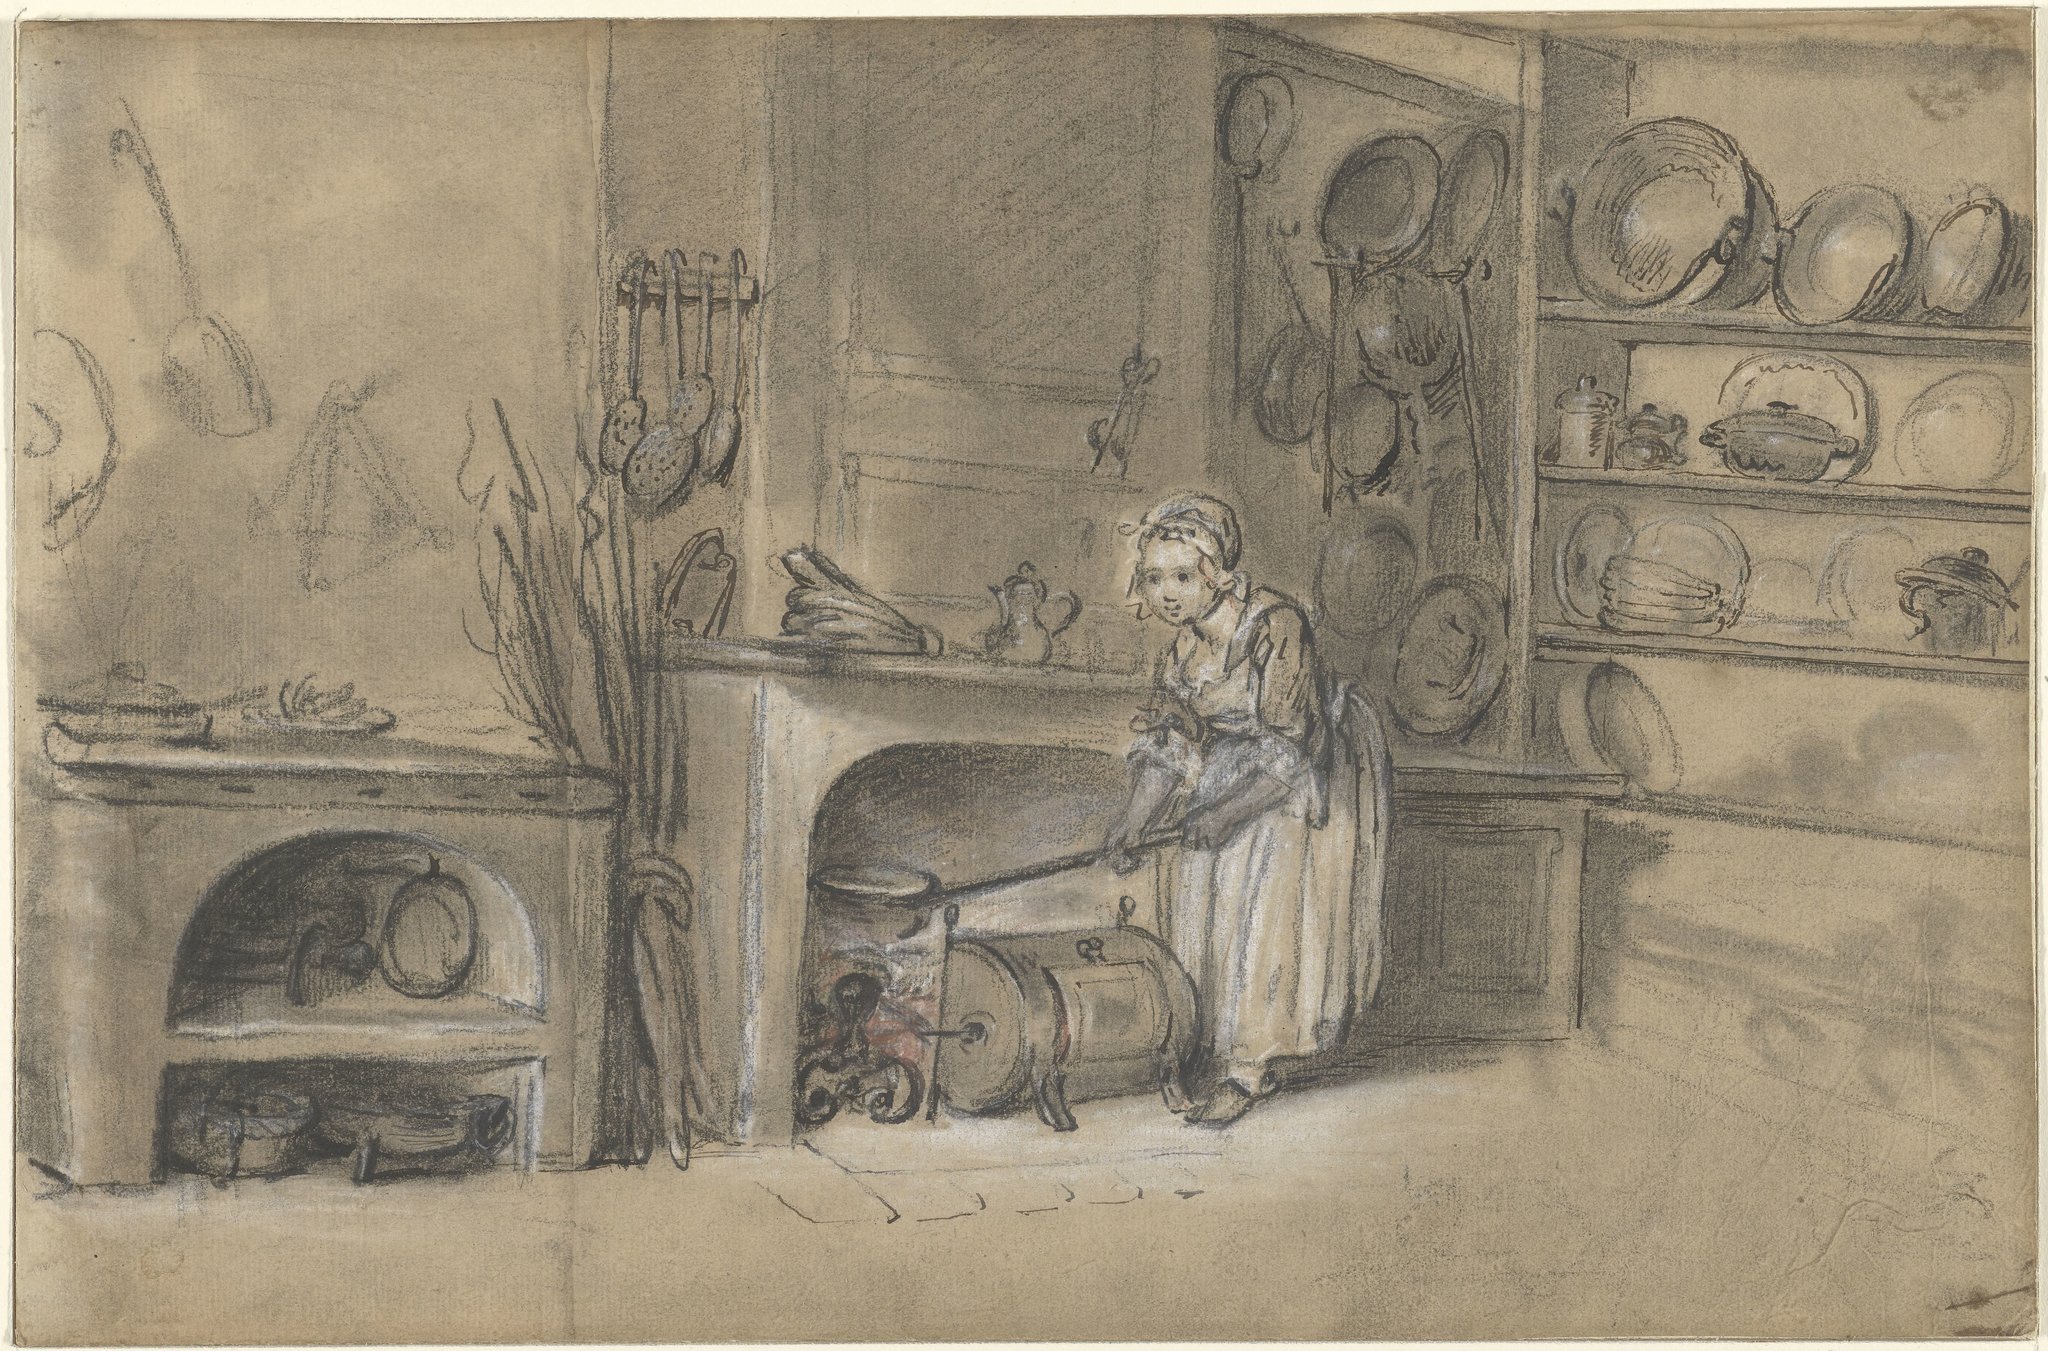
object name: drawing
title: Kitchen-sene with a Girl frying Pancakes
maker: louis aubert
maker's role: draughtsman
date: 1740-1780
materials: cardboard, chalk, ink, paper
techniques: pen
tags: kitchen, pancakes, kitchen-maid, kitchen servant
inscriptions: inscription, verso, lower left, pencil: ‘Erworben auf der auktion Müller Amsterdam, 1913’, collector's mark, verso, lower left: Lugt 2228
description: Keukeninterieur: een meisje houdt een steelpan boven het vuur.